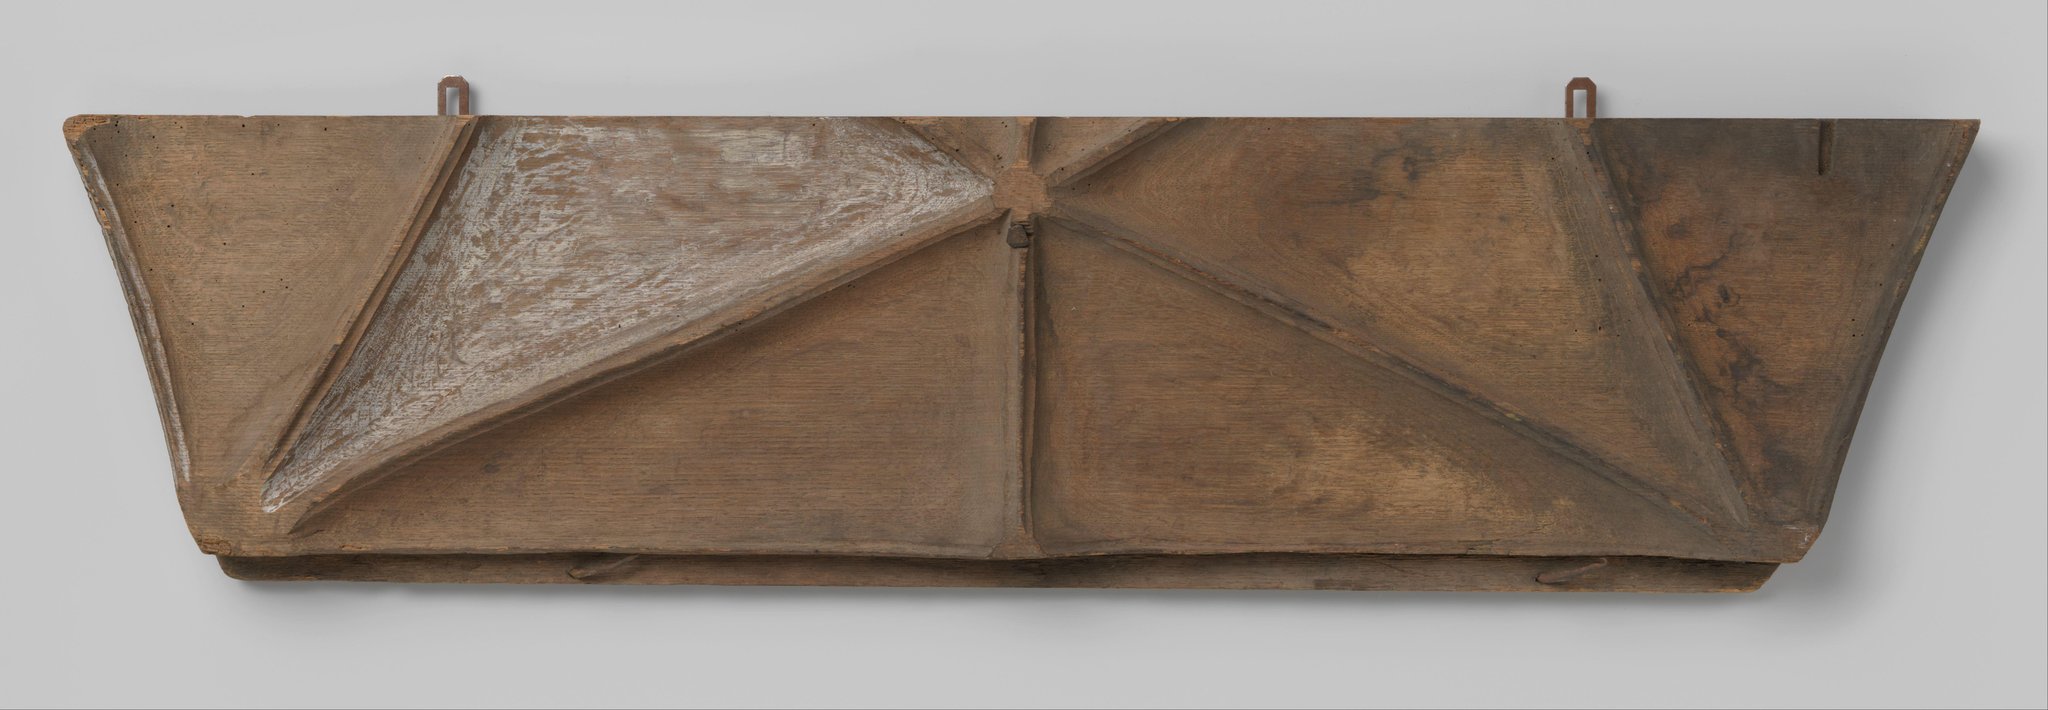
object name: furniture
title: Hemel van een baldakijn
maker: Anonymous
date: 1400-1950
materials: wood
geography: netherlands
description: Eikenhouten hemel van een baldakijn. Mogelijk kerkmeubilair.